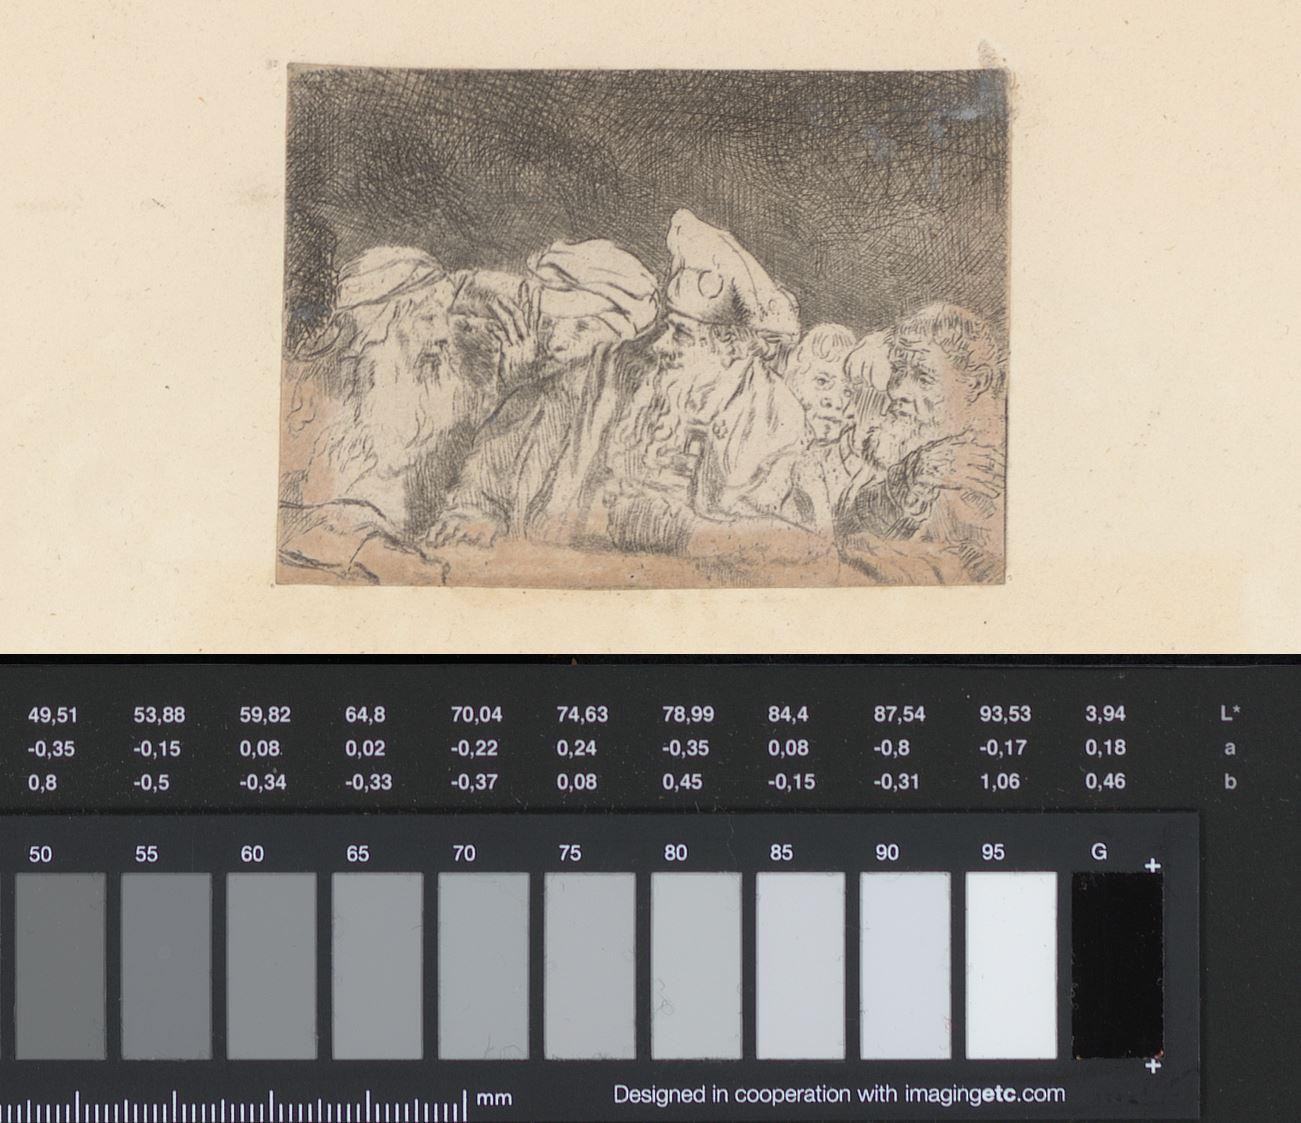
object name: album leaf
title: The Hundred Guilder Print: the figures leaning on the wall in the centre left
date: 1753-1810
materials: paper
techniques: drypoint, etching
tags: christ preaching in the open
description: Fragment van versneden plaat van de Honderdguldenprent. De prent maakt deel uit van een album.